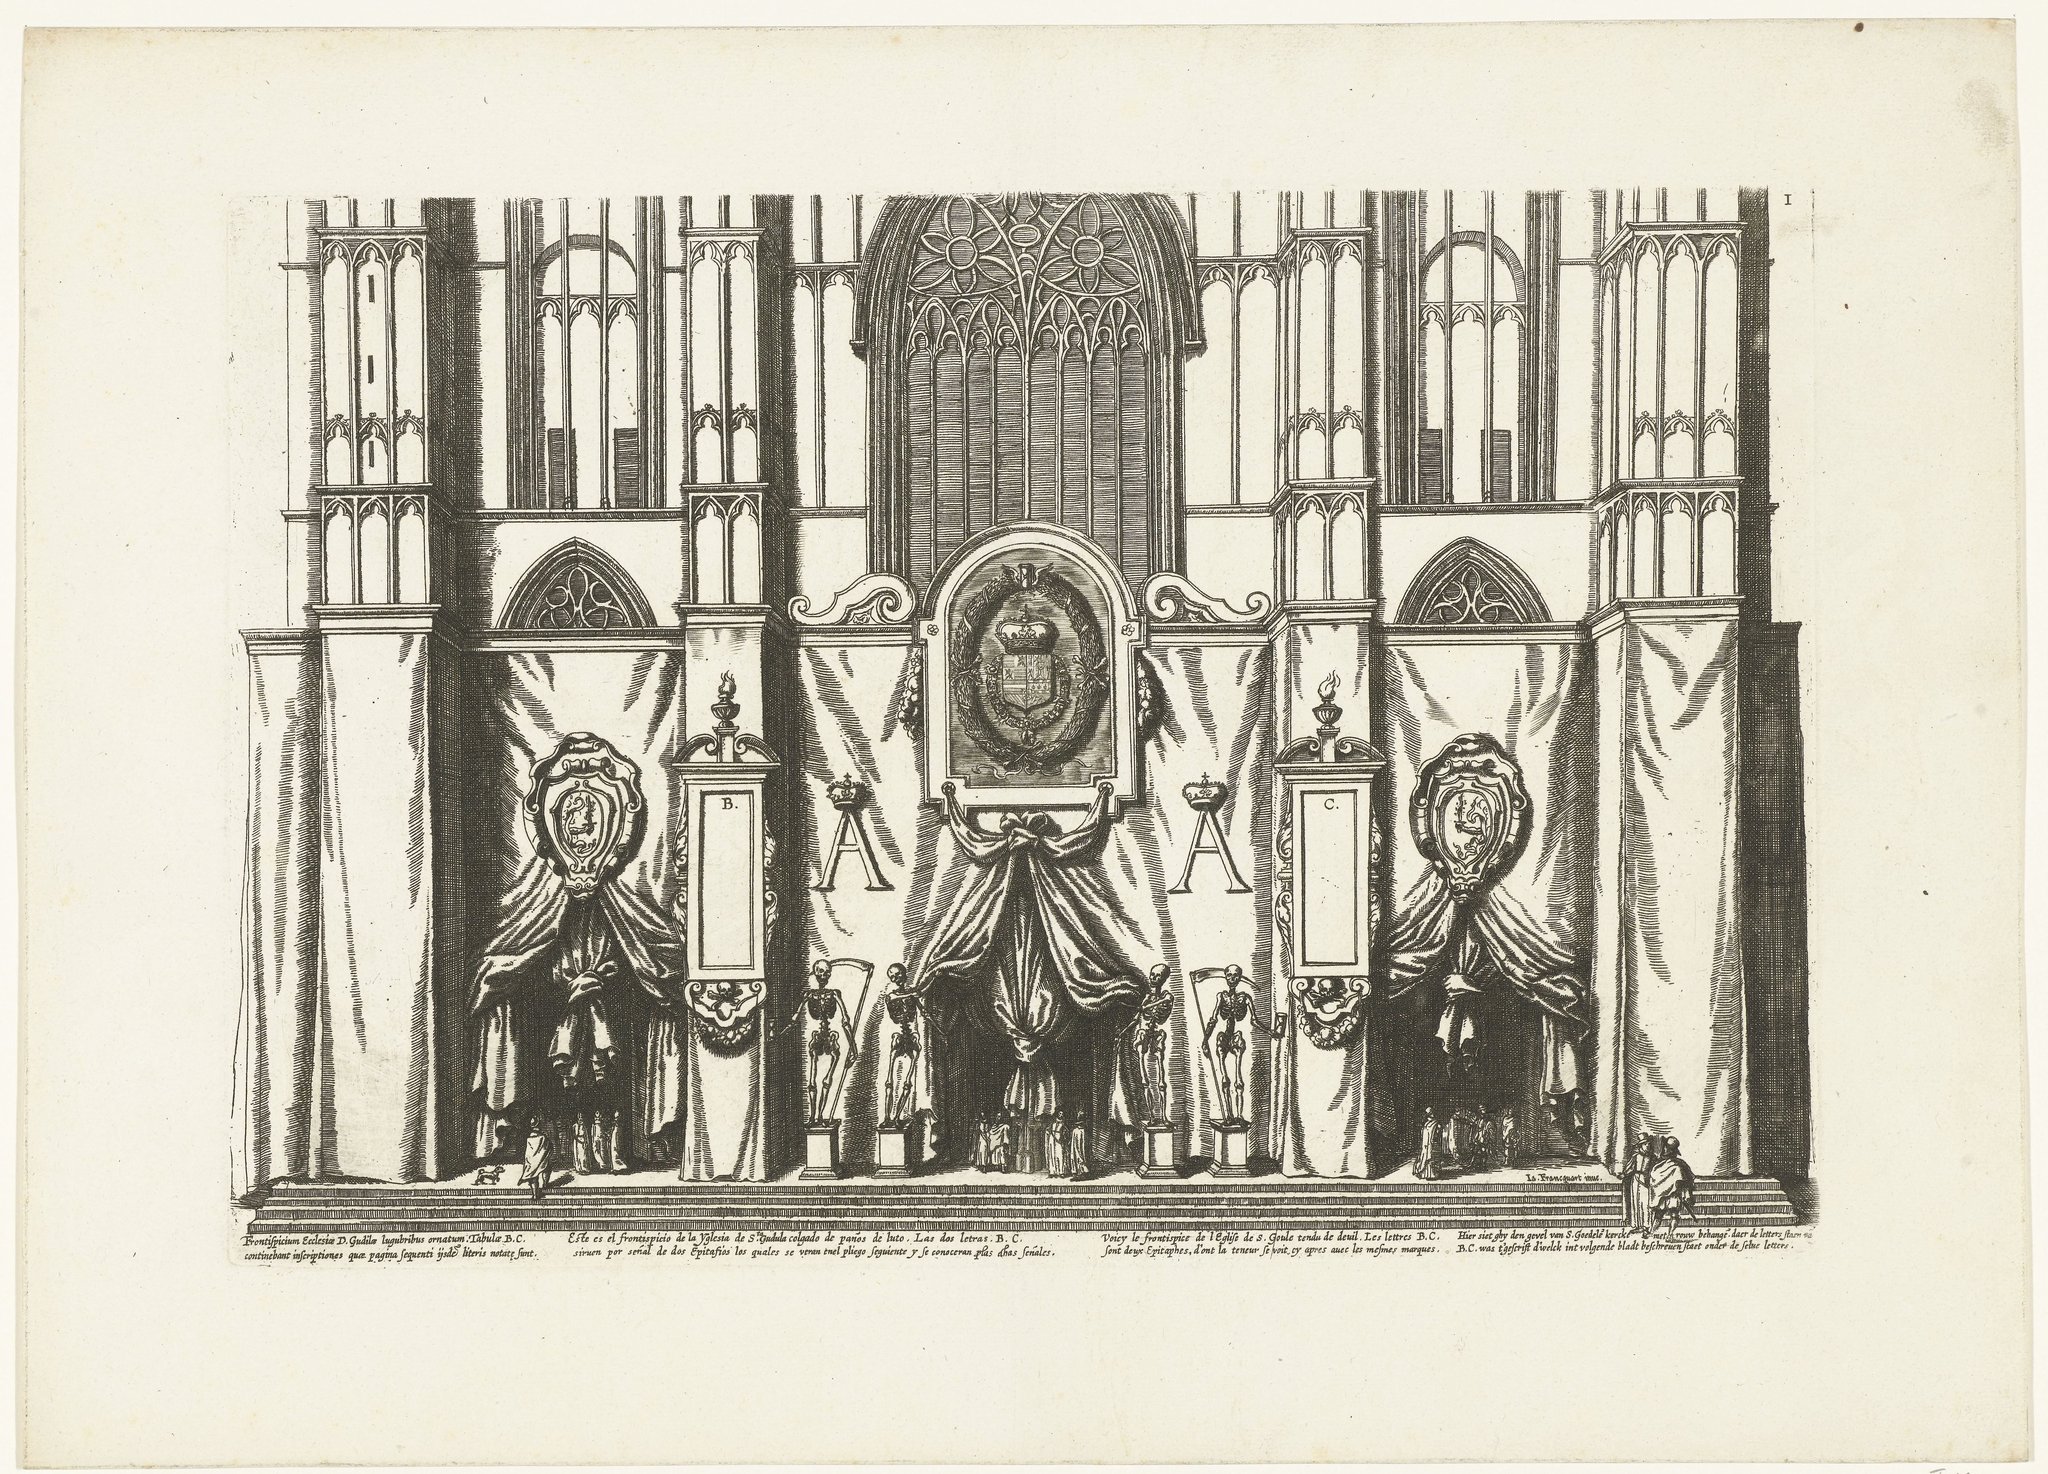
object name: print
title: Begrafenis van aartshertog Albrecht, 1622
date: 1623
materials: paper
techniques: engraving, etching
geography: southern netherlands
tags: cortege, funeral procession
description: De gevel van de Sint Gudula kerk te Brussel bekleed met rouwkleden, wapens en vier skeleten bij de ingang. Met onderschrift van 4 keer 2 regels in het Latijn, Spaans, Frans en Nederlands. Plaat I in de serie van de begrafenis van aartshertog Albrecht van Oostenrijk te Brussel op 12 maart 1622.